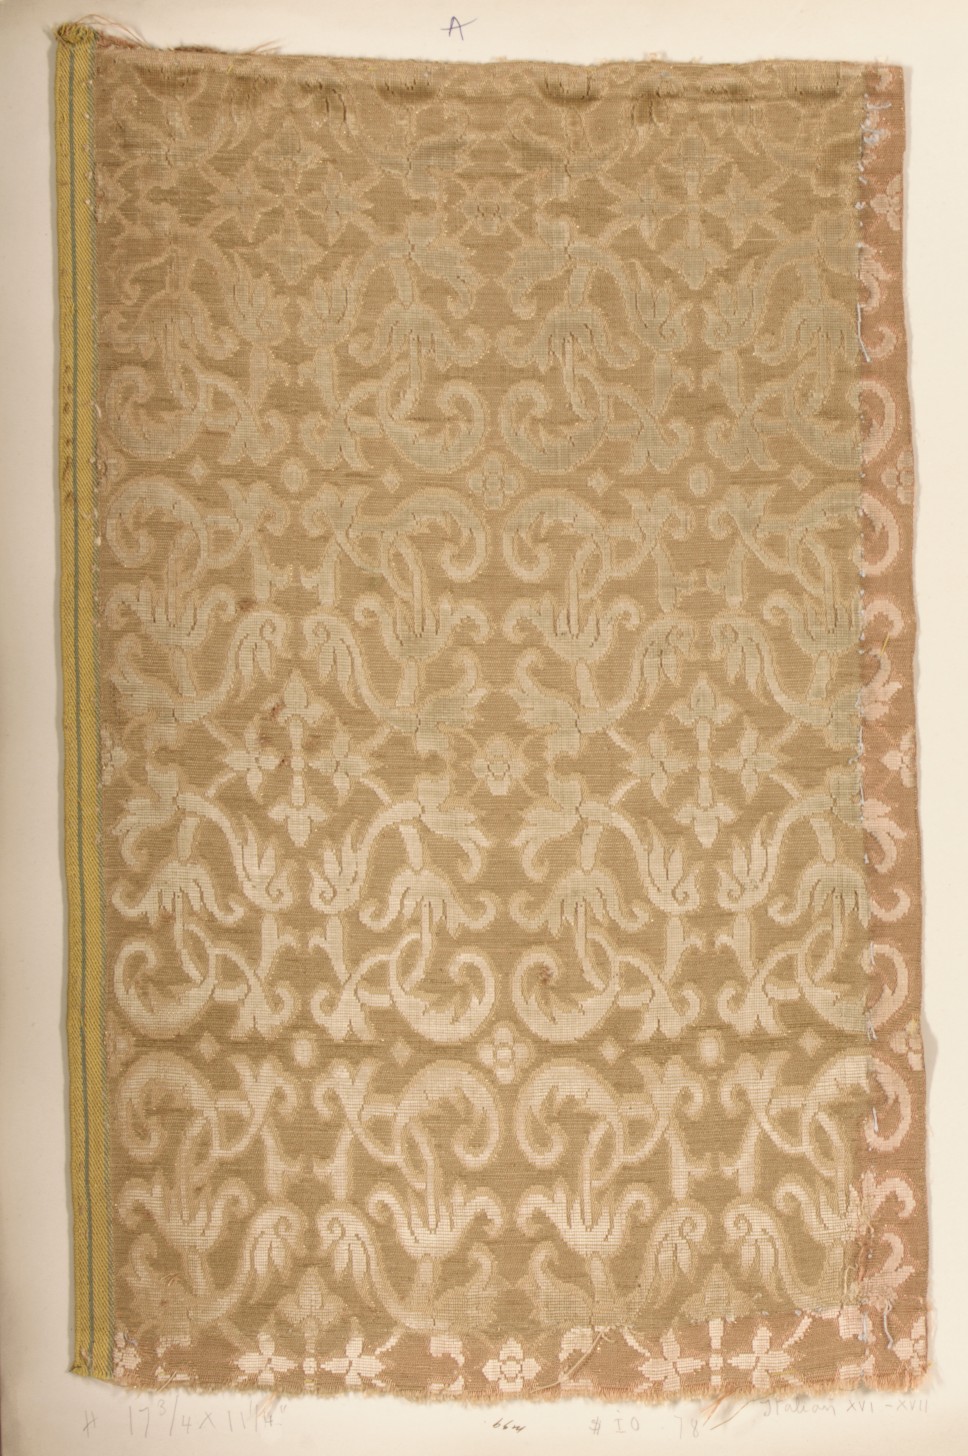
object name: fragment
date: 1567-1633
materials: metal thread, silk